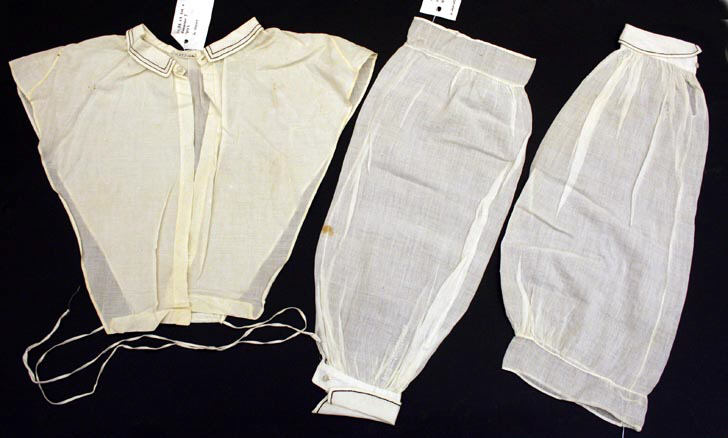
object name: accessory set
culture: european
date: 1850-1859